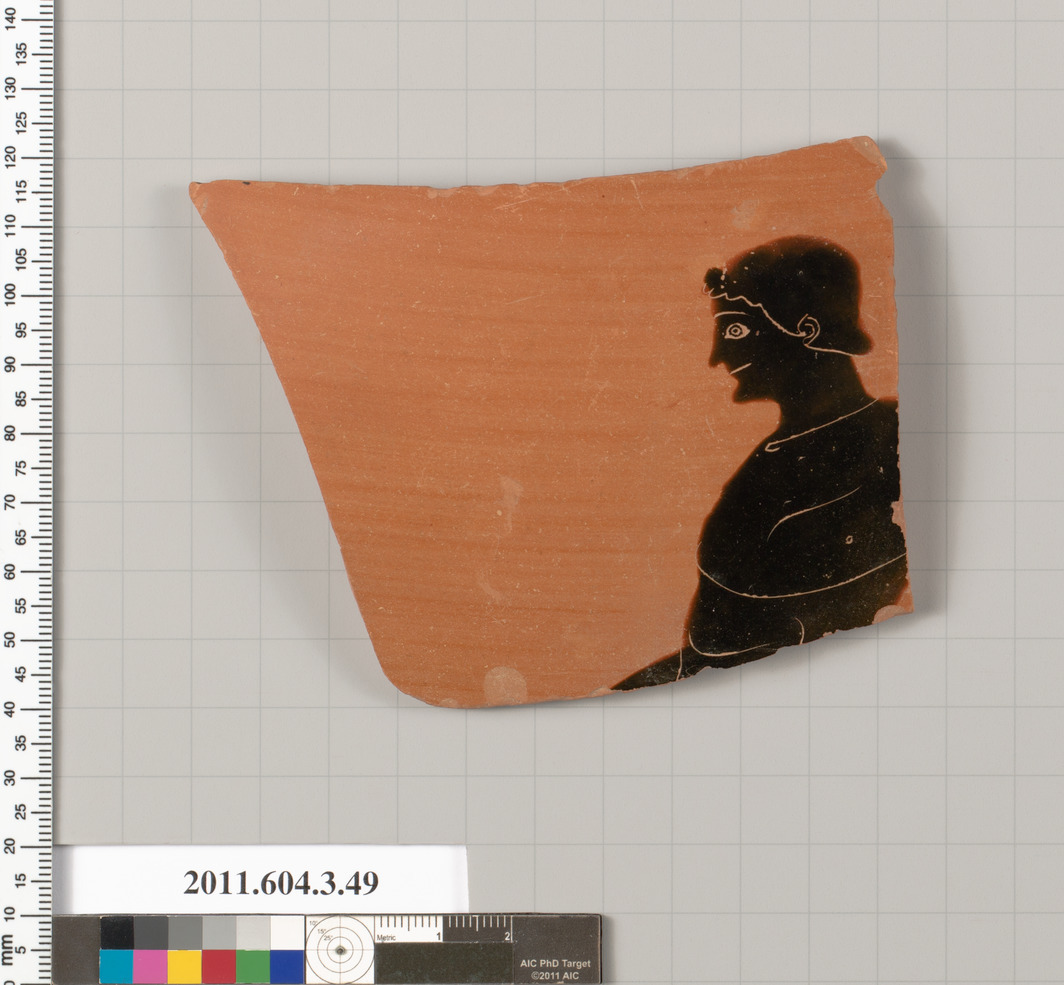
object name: amphora fragment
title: Terracotta fragment of an amphora (jar)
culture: greek, attic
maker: michigan painter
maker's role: artist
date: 510-500 BCE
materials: terracotta